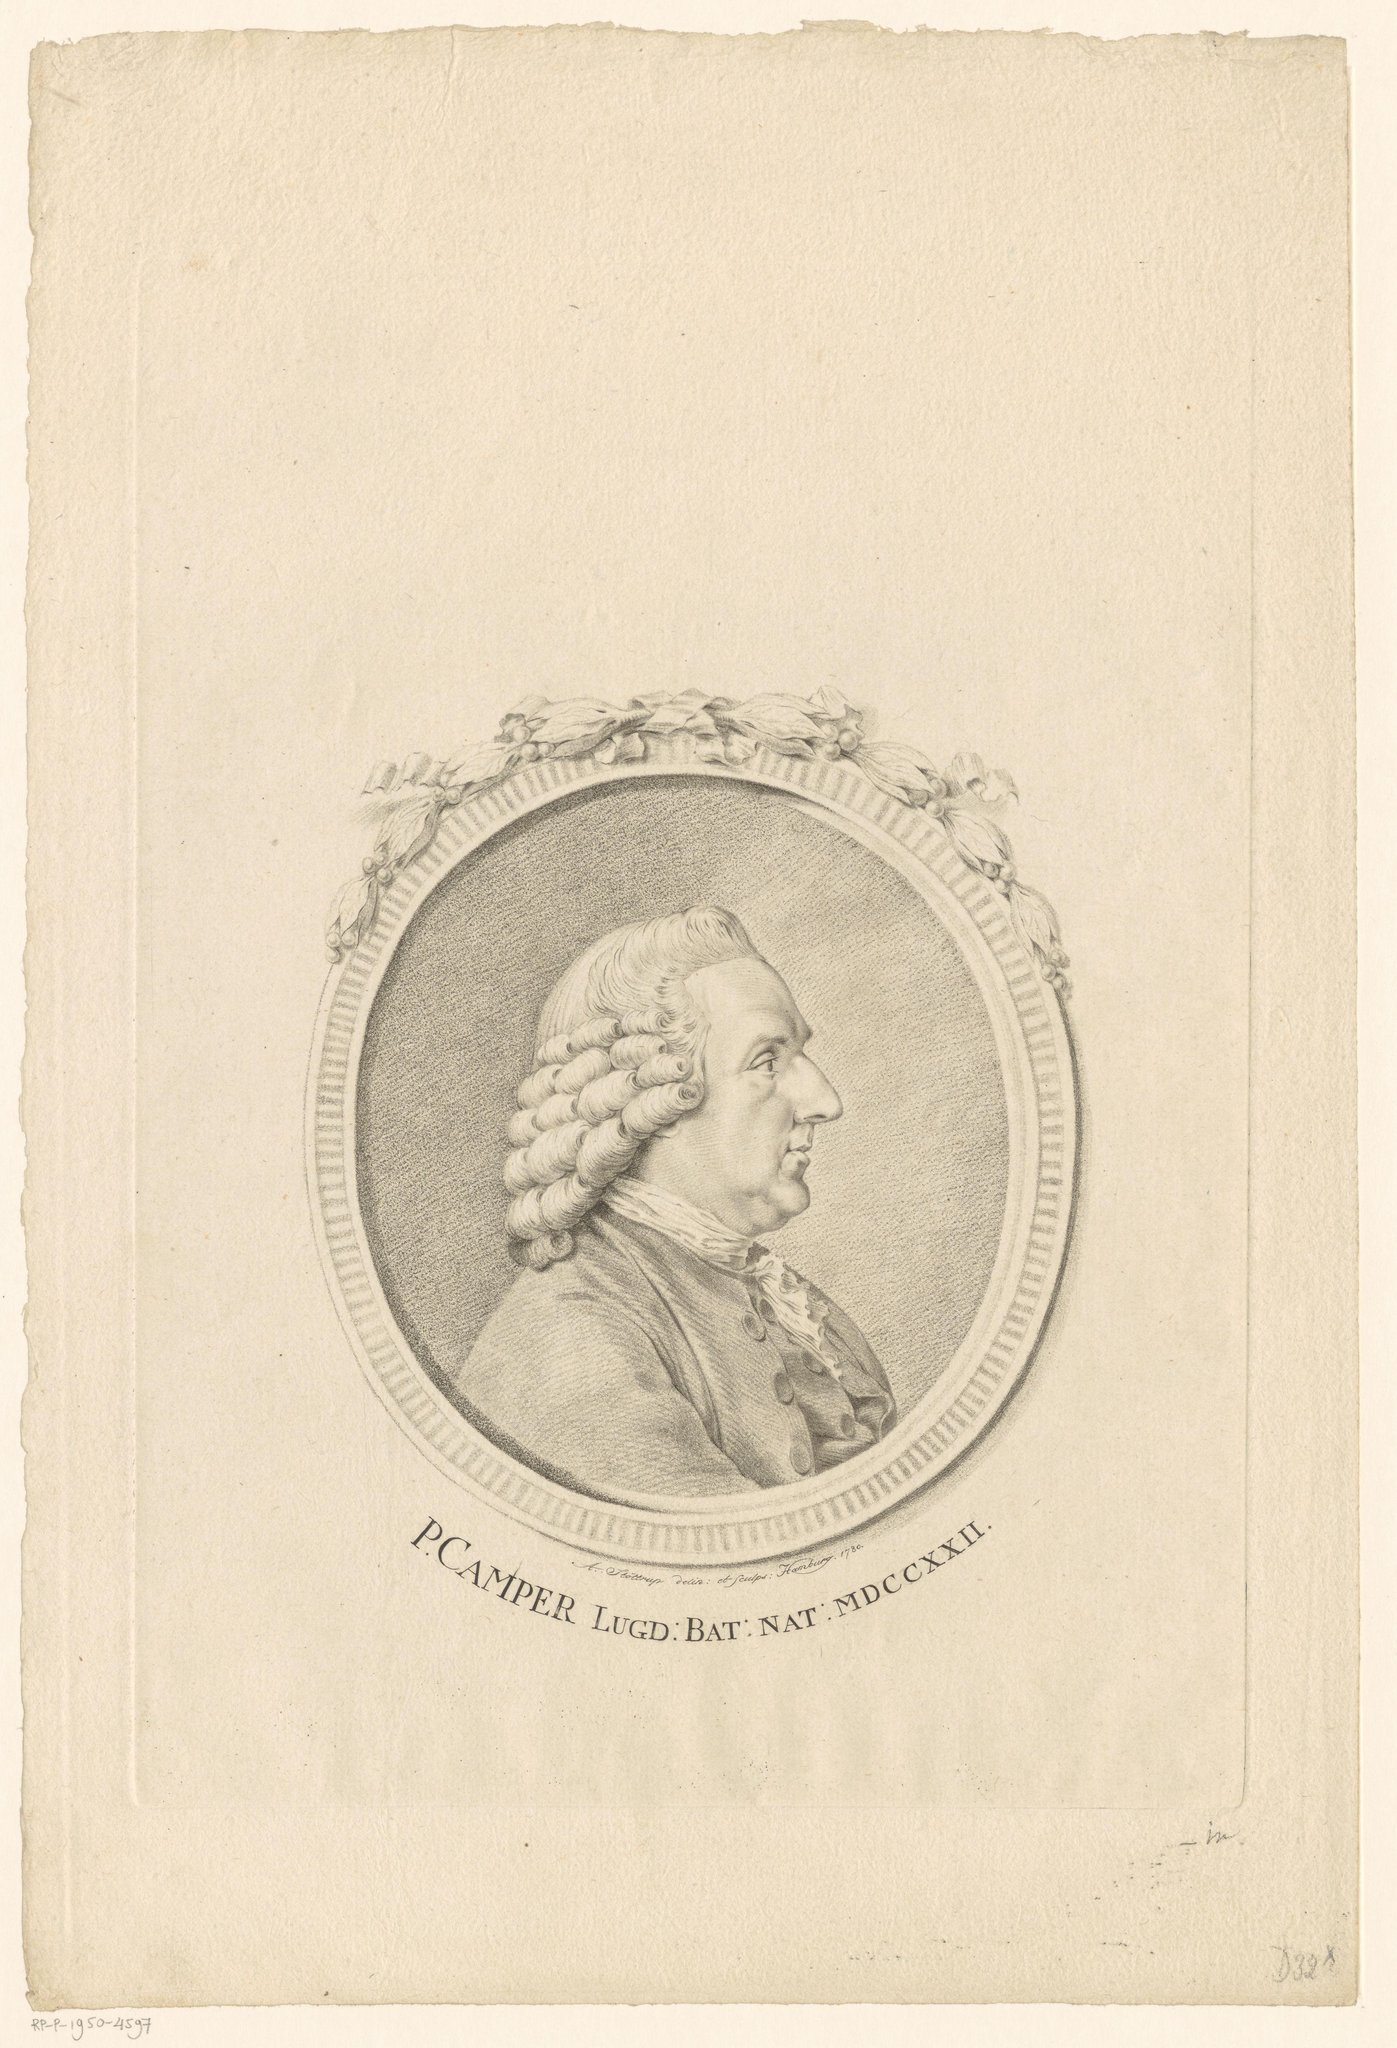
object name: print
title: Portret van Petrus Camper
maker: andreas stöttrup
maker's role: draughtsman, painter, print maker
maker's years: 1751-1812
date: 1780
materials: paper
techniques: printmaking, etching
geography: hamburg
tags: leiden, the hague, print maker, draughtsman, petrus camper, historical persons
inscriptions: collector's mark: Lugt 2228